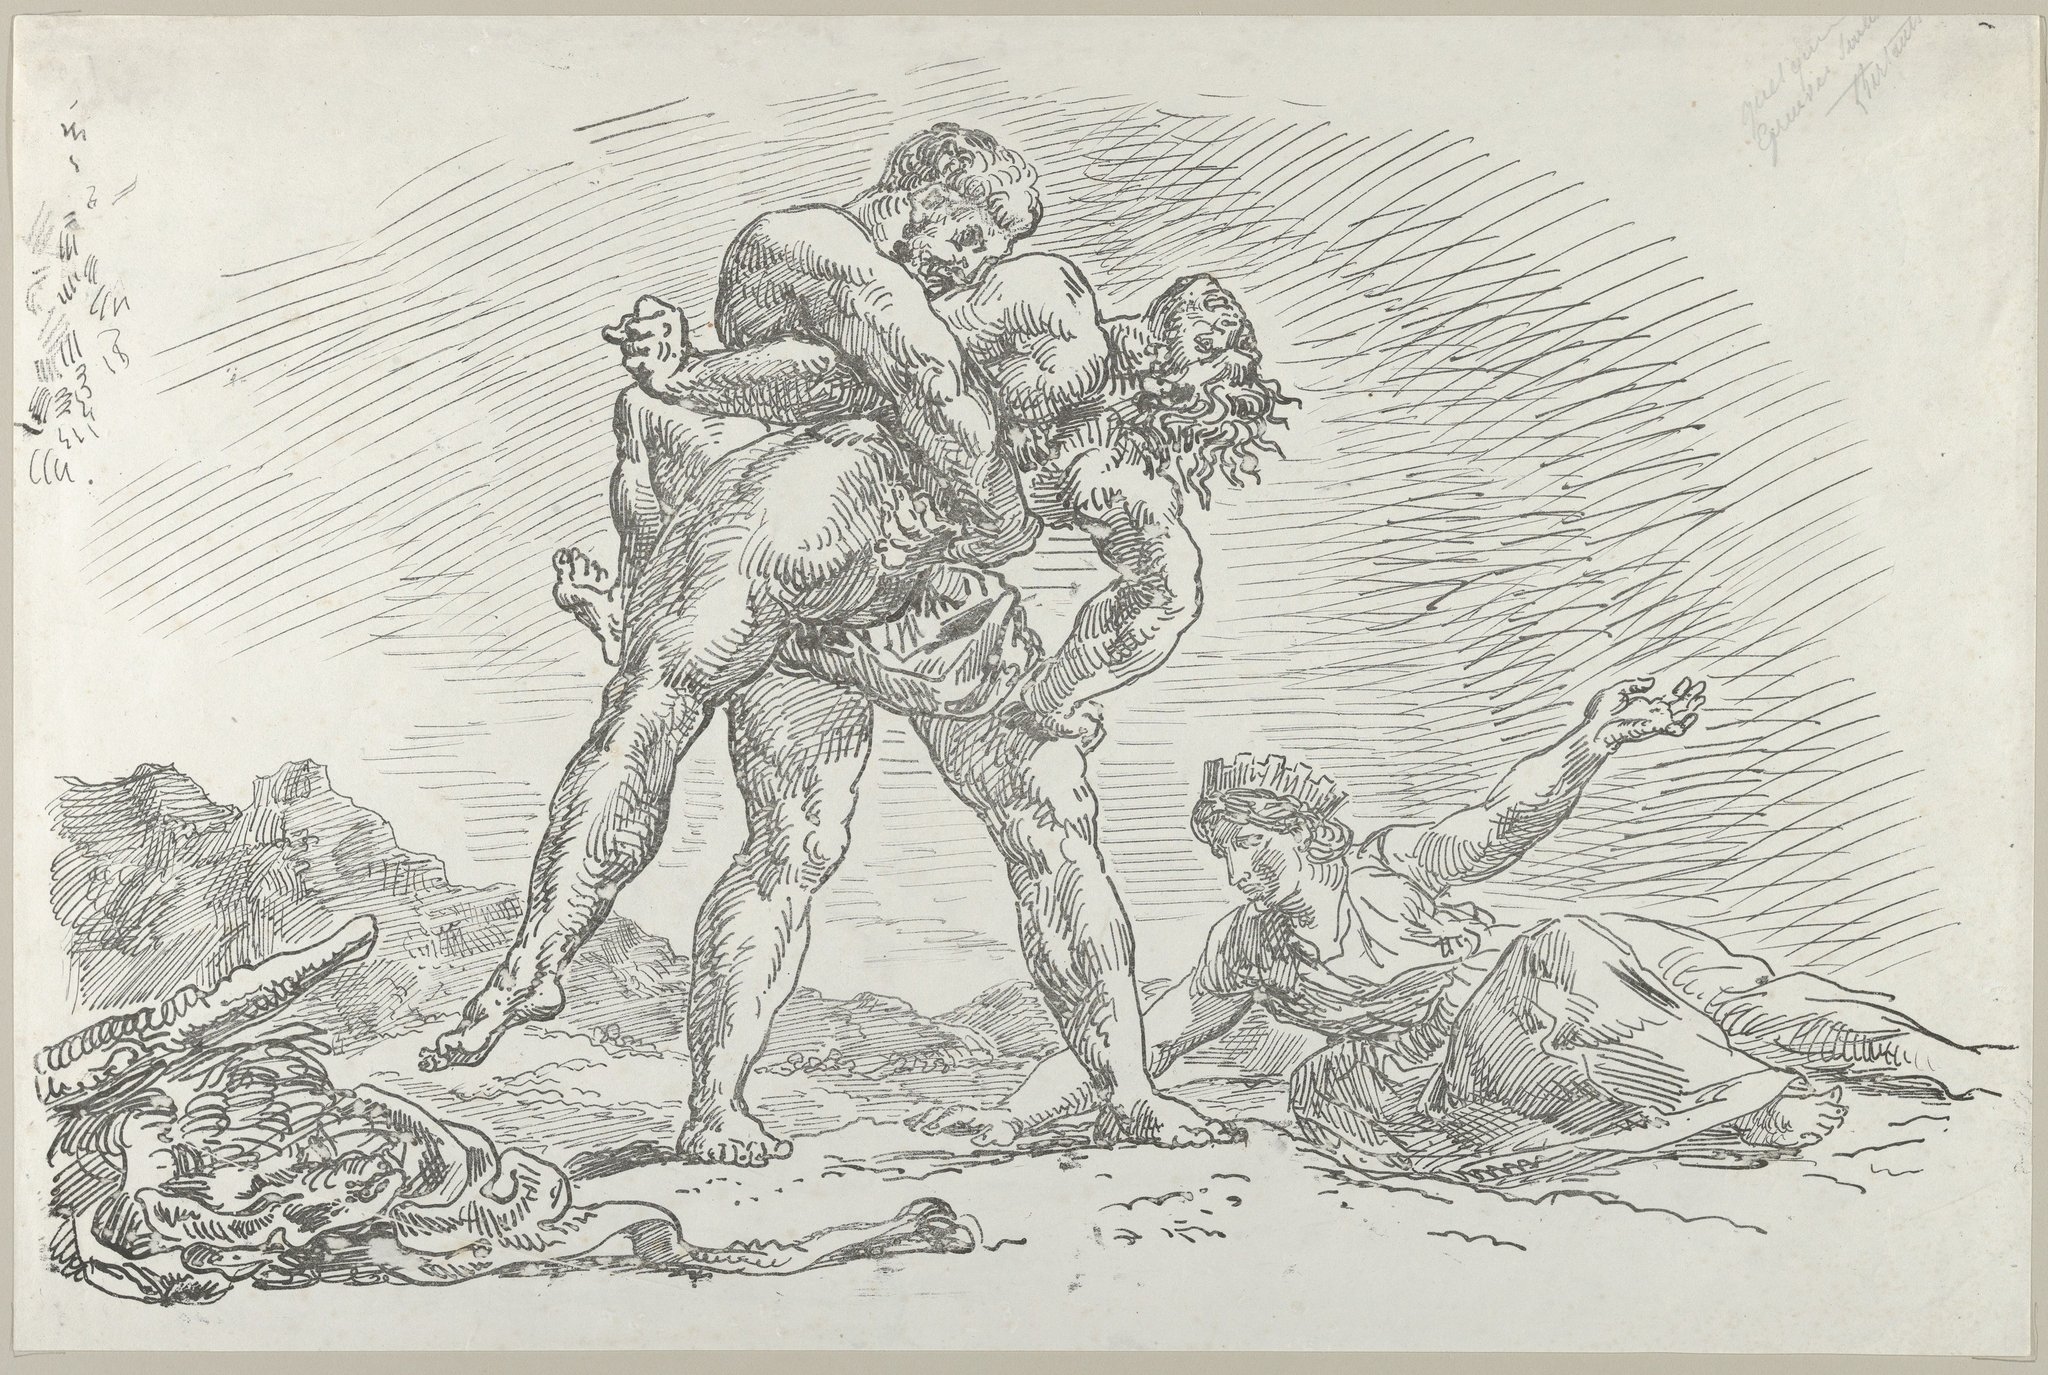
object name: print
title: Hercules and Antaeus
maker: eugène delacroix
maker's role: artist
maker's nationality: french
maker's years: 1798-1863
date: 1852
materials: paper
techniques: lithograph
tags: women,hercules